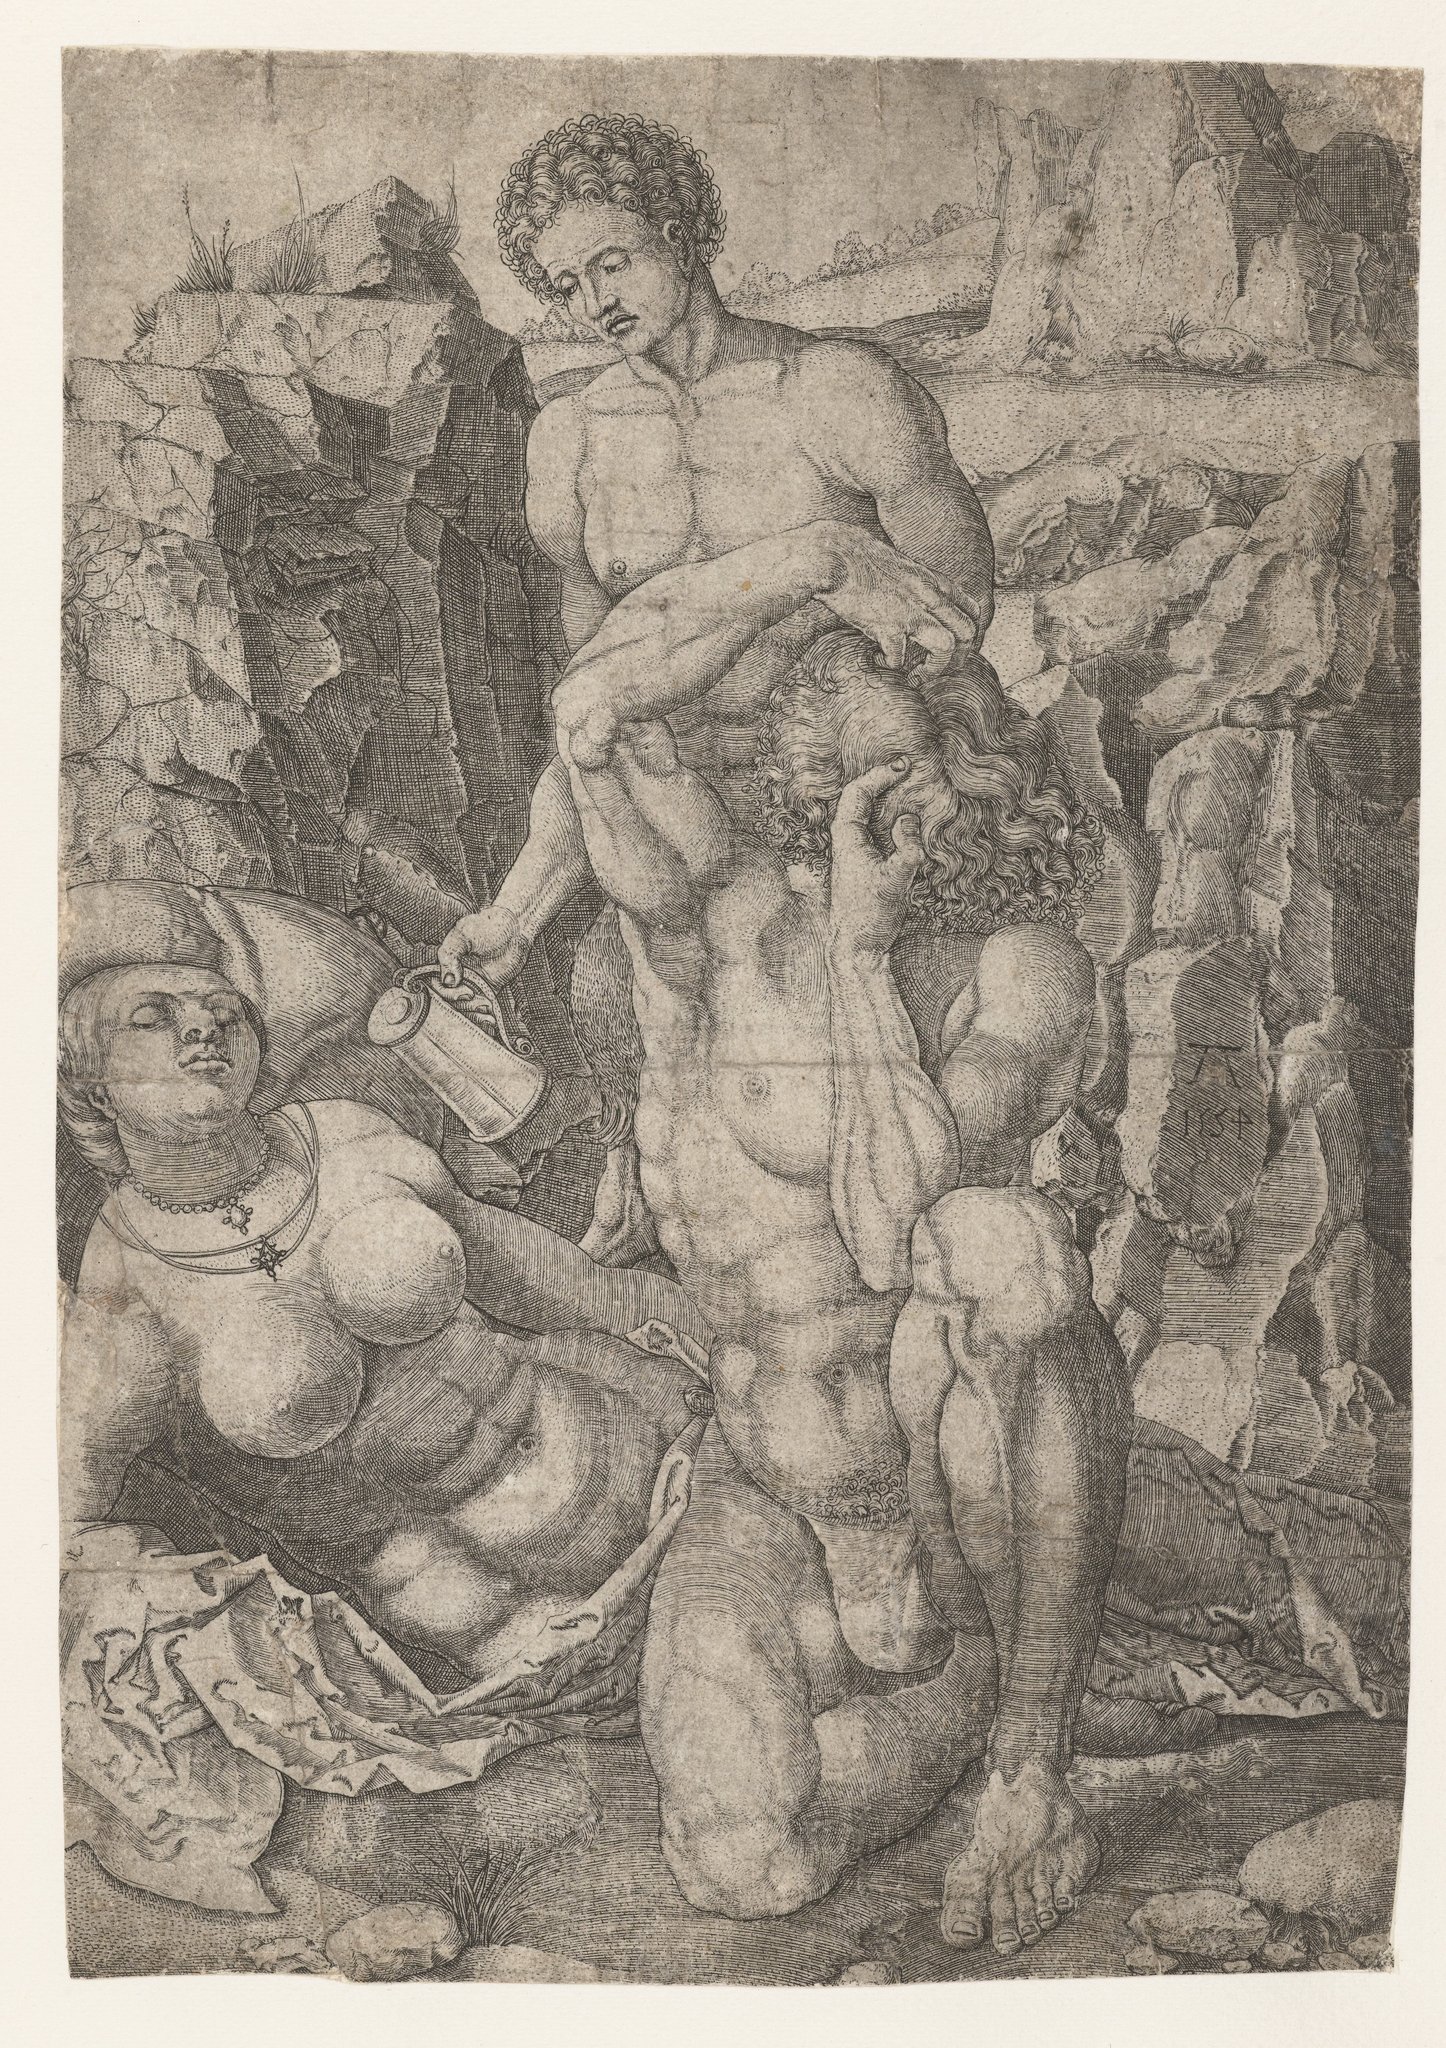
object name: print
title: De waanzin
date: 1554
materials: paper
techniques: engraving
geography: low countries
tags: emotional illness, derangement, madness, (almost) naked ~ ascetic life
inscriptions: collector's mark: Lugt 240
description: Rotslandschap met drie figuren. Halfnaakte man met handen in haar, vrouw met ontbloot bovenlichaam slapend en man met kan in rechterhand.